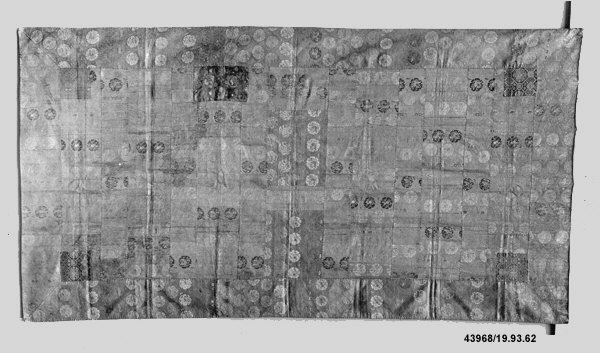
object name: robe, priest's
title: Priest's Robe (Shichijō)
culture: japanese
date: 1673-1681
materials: metal thread, silk